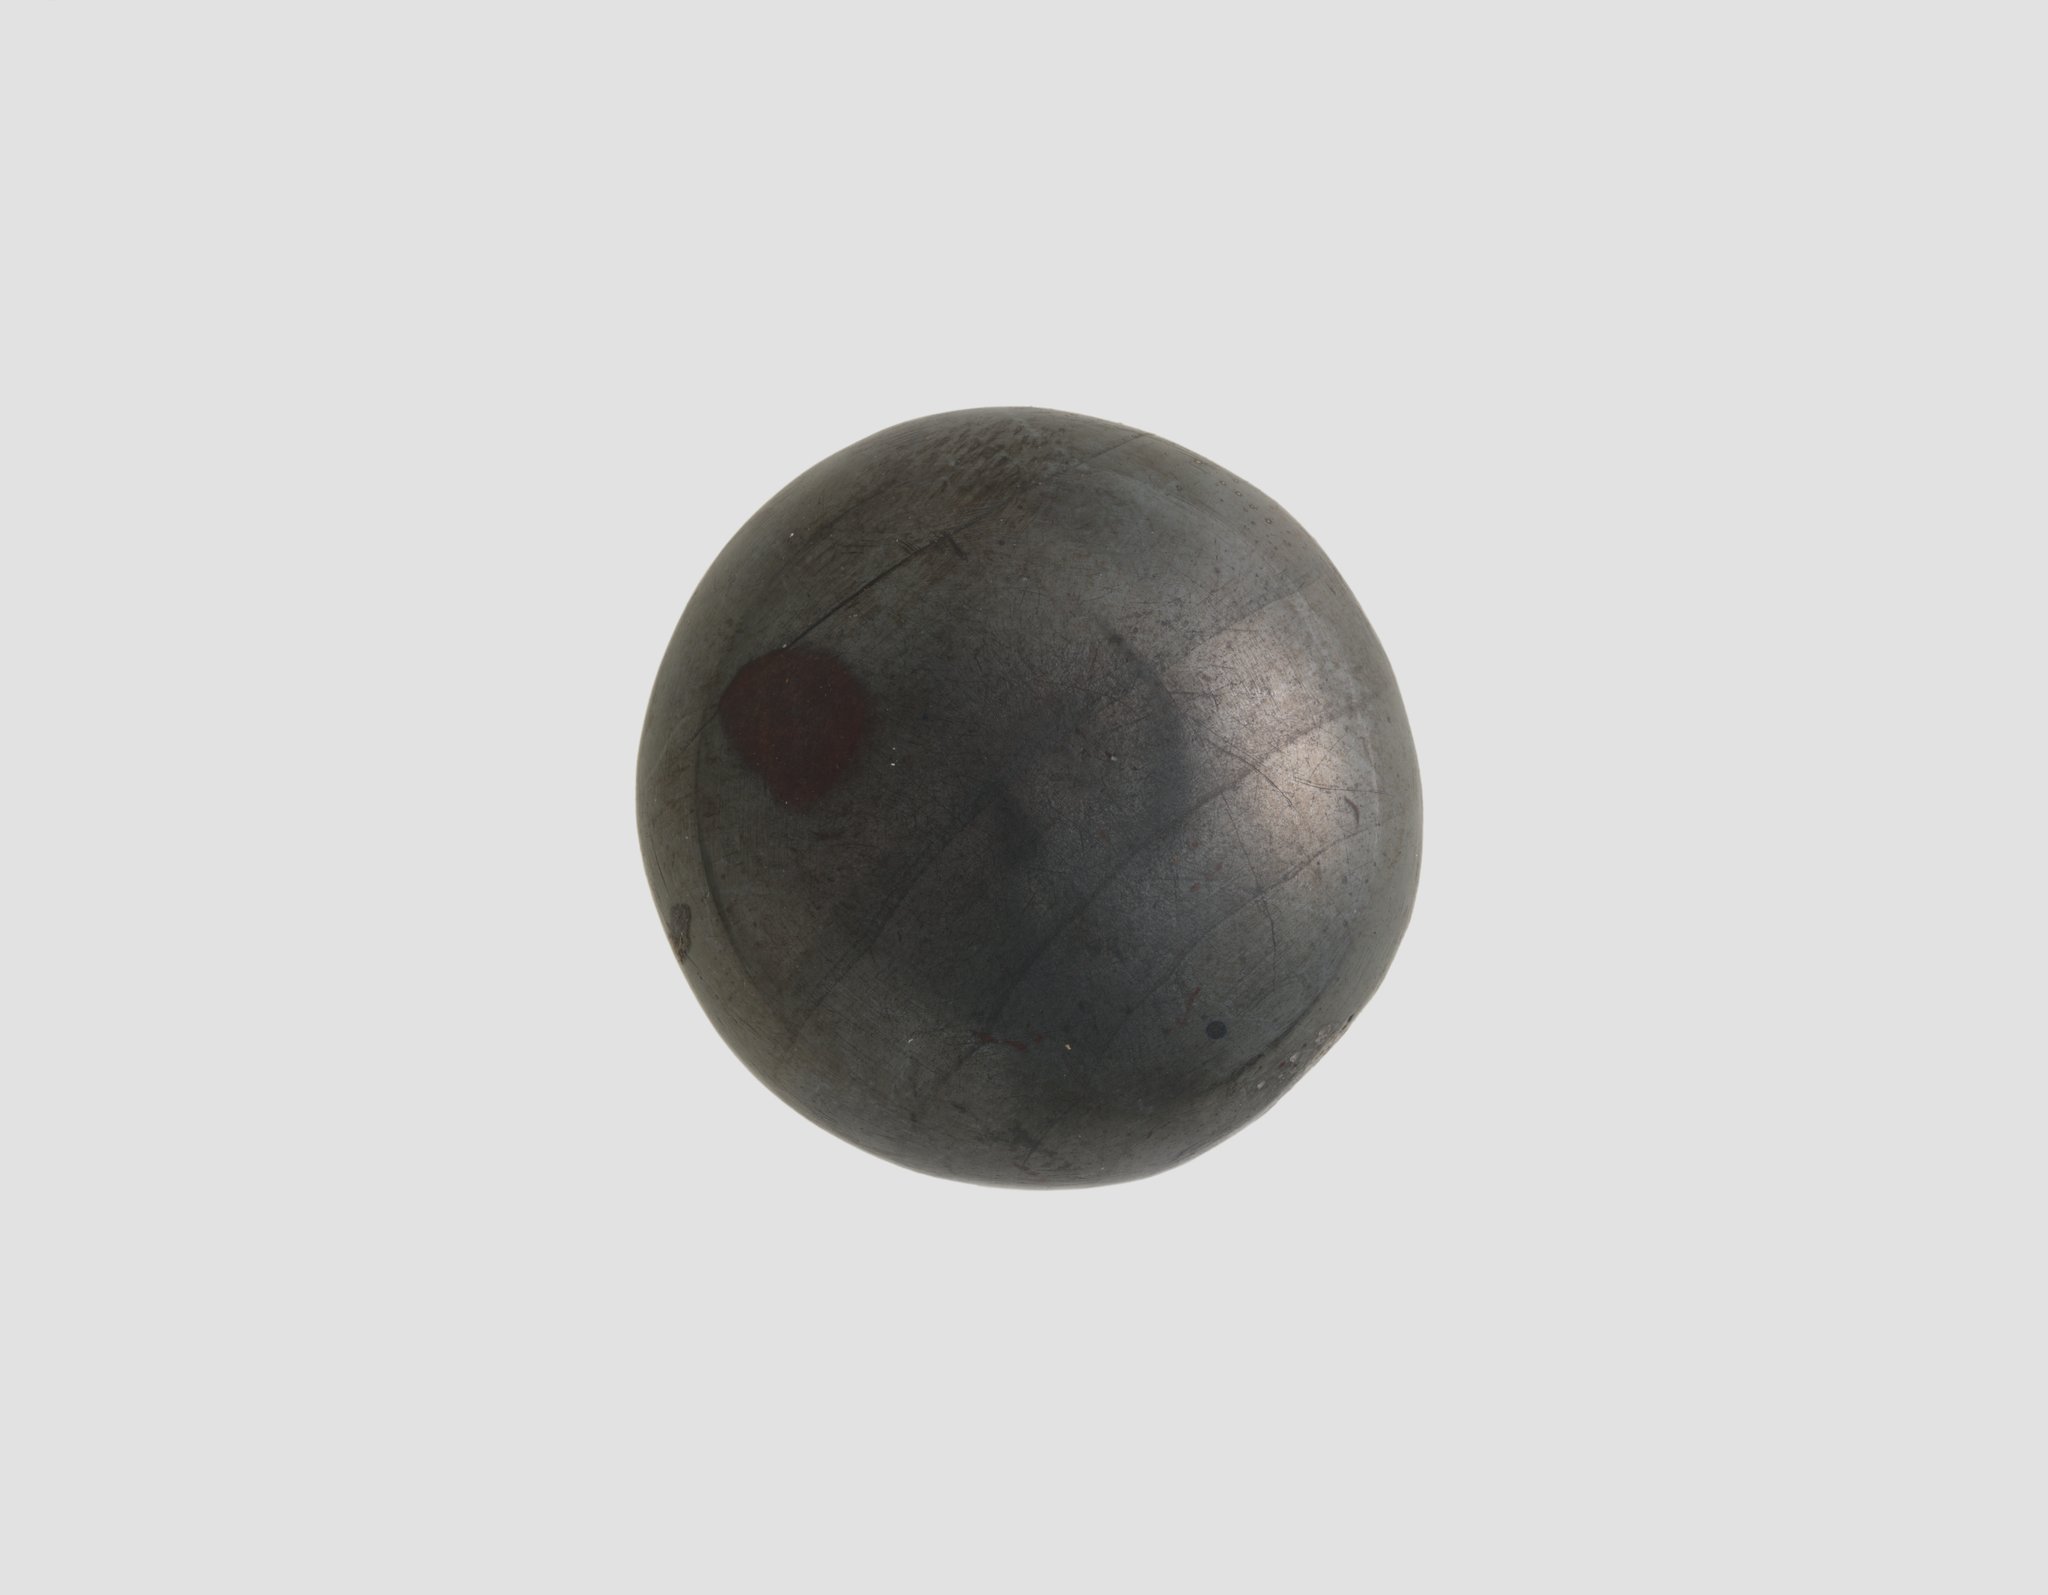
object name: weight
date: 3000-1 BCE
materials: mineral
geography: cyprus or western asia